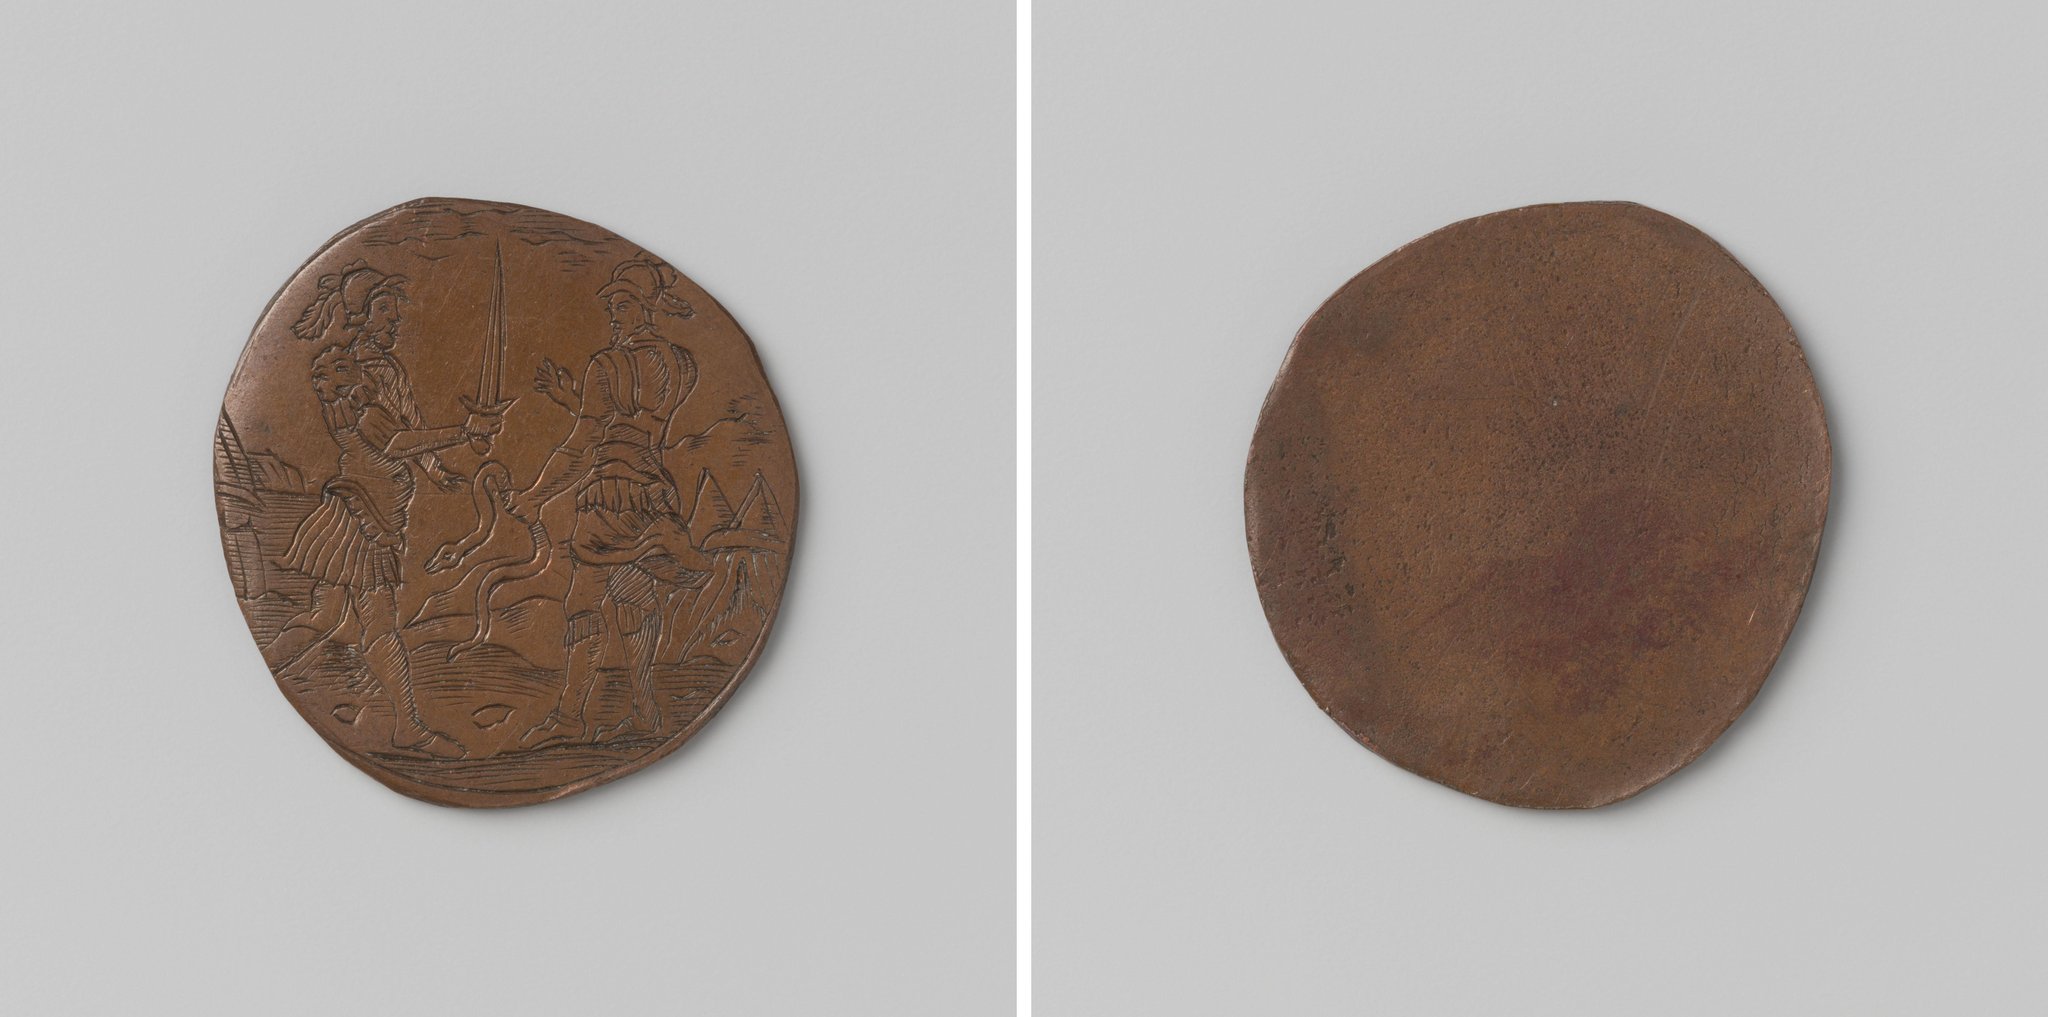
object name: medal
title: Vechtende soldaten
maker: Anonymous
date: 1600-1700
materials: copper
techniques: engraving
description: Eenzijdig gegraveerde koperen niet geheel ronde penning. Voorzijde: naar rechts gewende soldaat met geheven zwaard in rechterhand loopt toe op een tweede soldaat, die kronkelende slang in linkerhand houdt; op achtergrond: tenten van een legerkamp. Keerzijde: blanco.